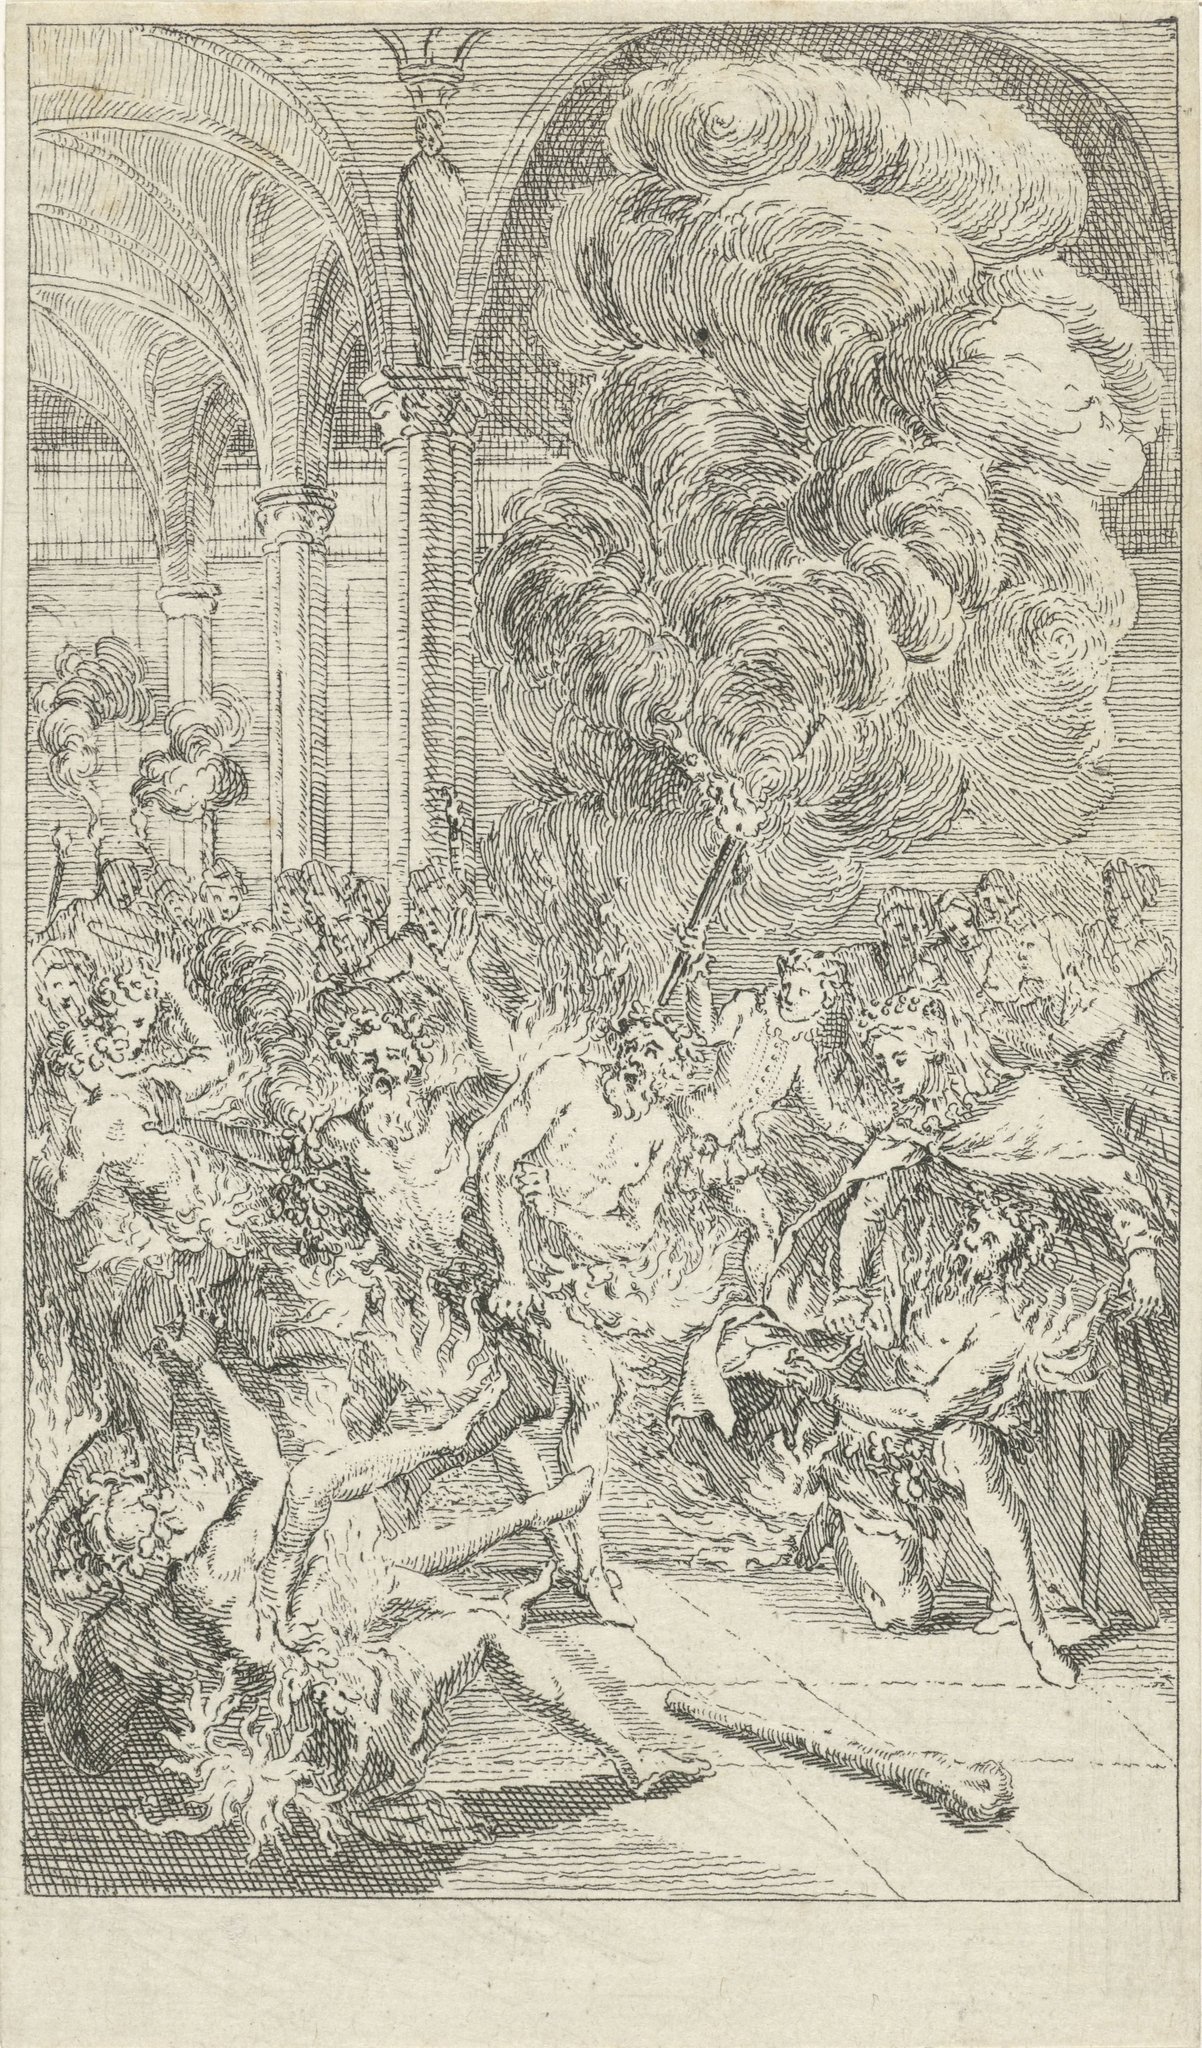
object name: print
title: Bal des Ardents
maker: bernard picart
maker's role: draughtsman, print maker, publisher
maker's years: 1673-1733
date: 1731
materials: paper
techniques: etching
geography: amsterdam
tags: palace - aa - civic architecture: inside, wedding reception, rescue from fire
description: Definitieve staat van deze prent als illustratie gebruikt in: Vanel, Claude, M., Henri Sauval. Galanteries des rois de France: depuis le commencement de la monarchie cenrichie de figures en taille-douce & augmentée des amours des rois de France sous plusieurs races, tirées de l'Histoire de la ville de Paris. Amsterdam: Charles Moette, 1731.